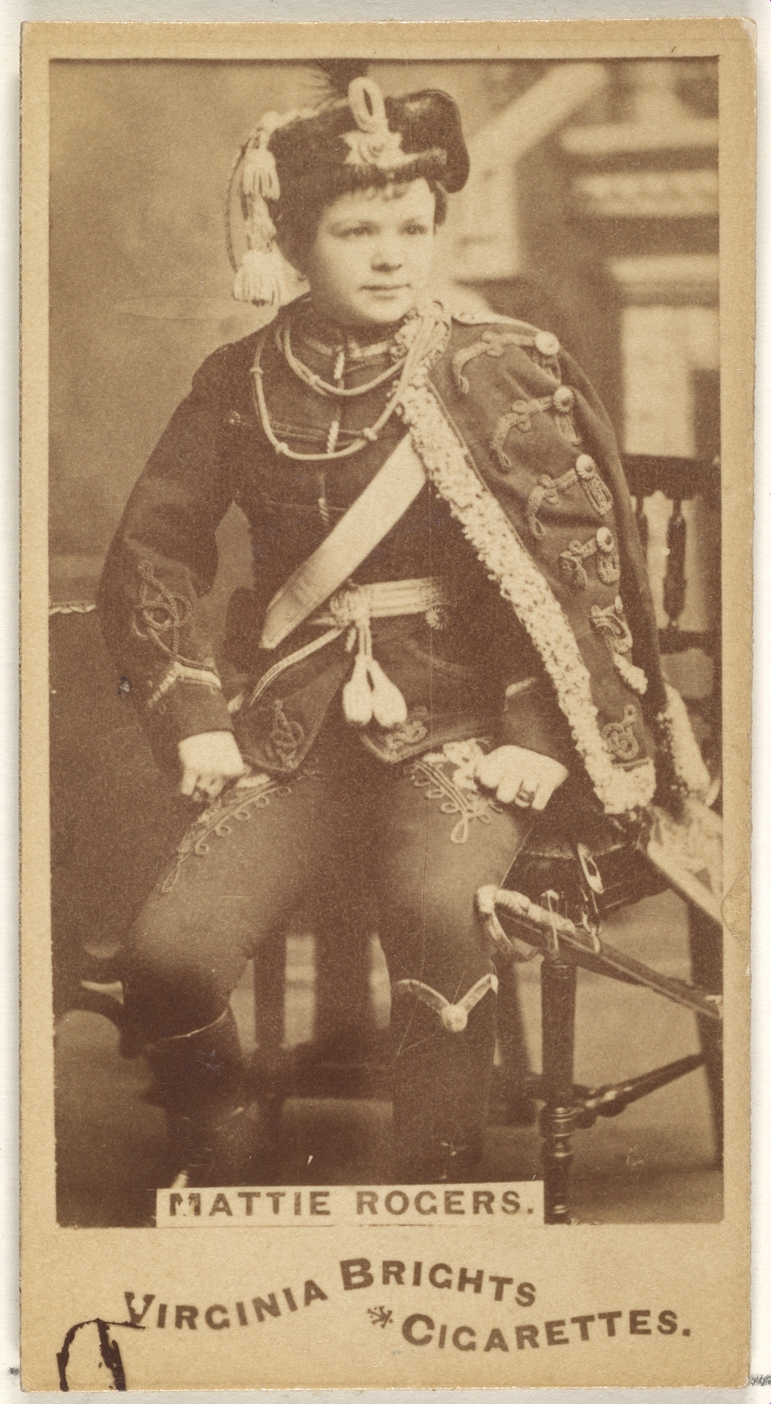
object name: photograph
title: Mattie Rogers, from the Actors and Actresses series (N45, Type 1) for Virginia Brights Cigarettes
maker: allen & ginter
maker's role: publisher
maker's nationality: american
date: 1888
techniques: albumen silver print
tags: portraits,women,actresses